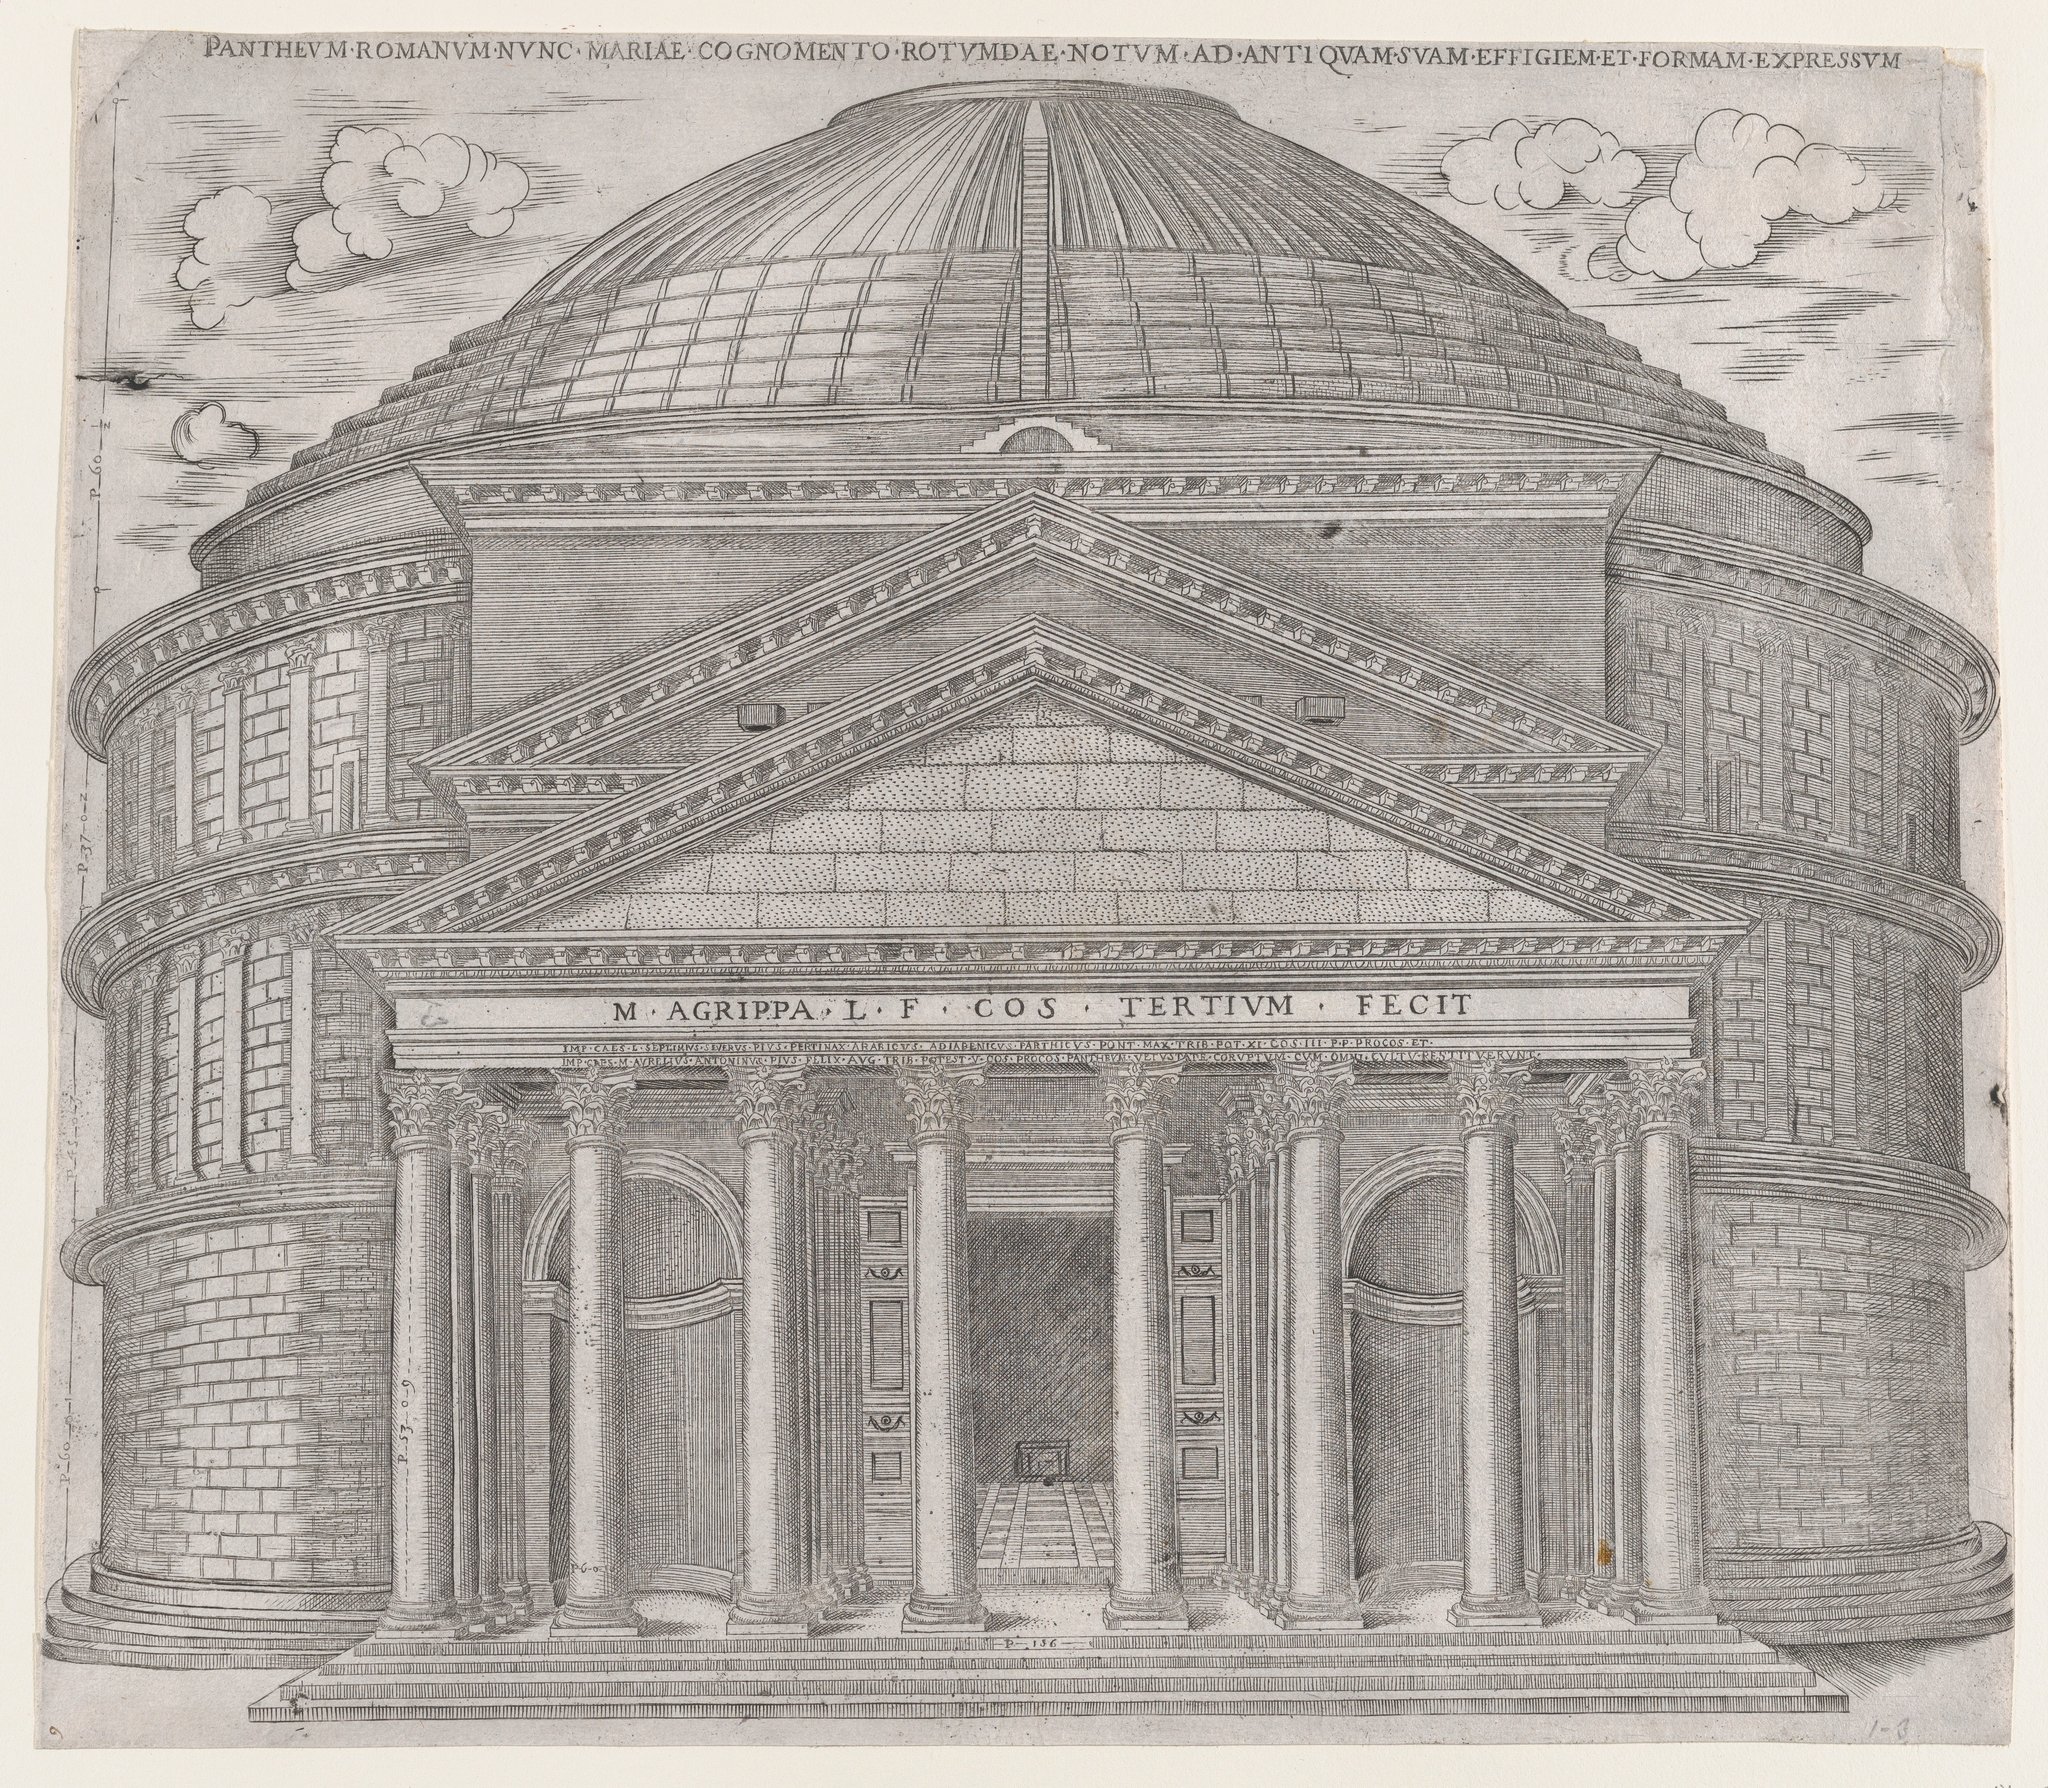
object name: print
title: The Pantheon, from "Speculum Romanae Magnificentiae"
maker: Anonymous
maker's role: artist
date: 1501-1600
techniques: engraving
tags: architecture,buildings,rome